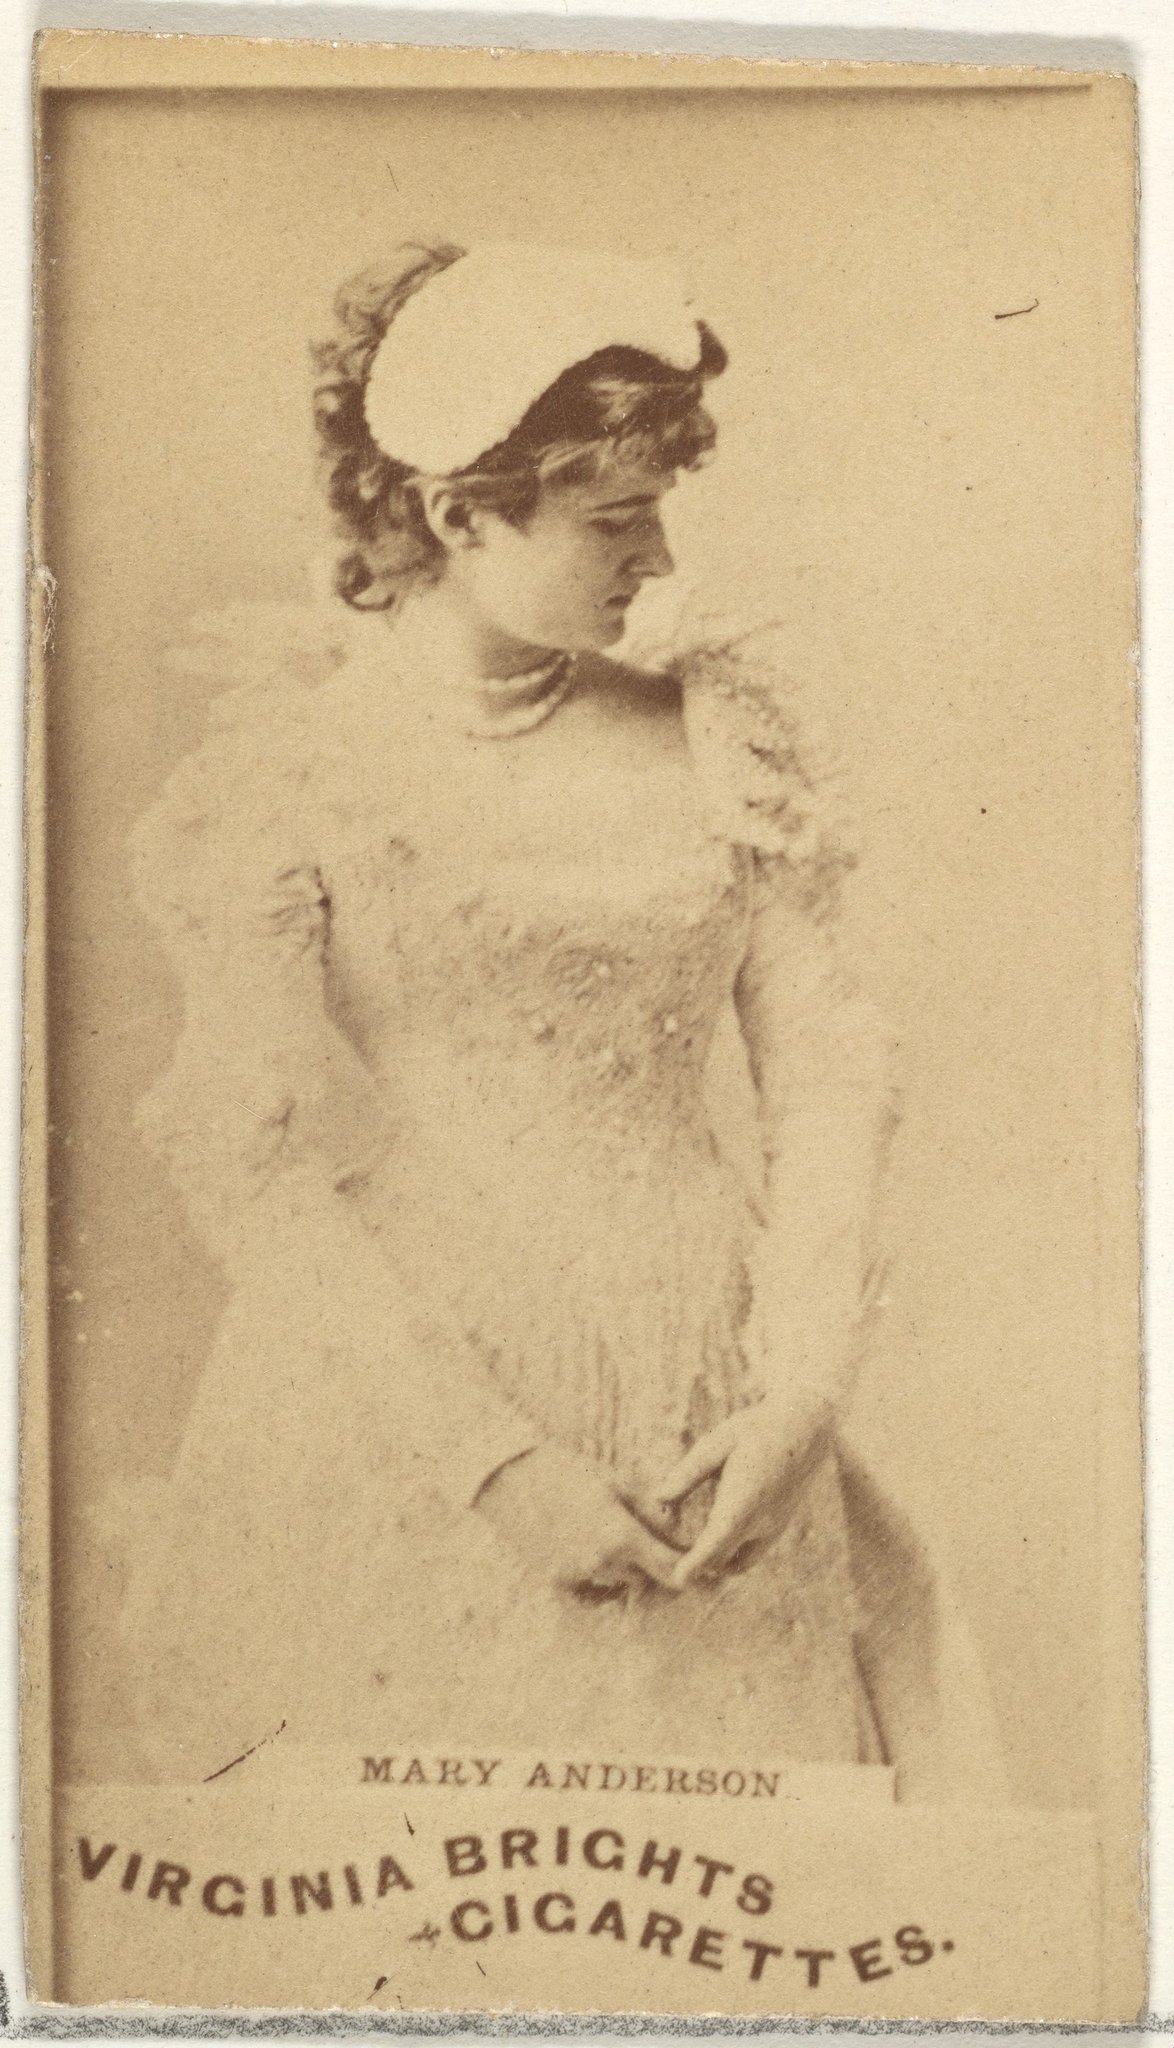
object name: photograph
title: Mary Anderson, from the Actors and Actresses series (N45, Type 1) for Virginia Brights Cigarettes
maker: allen & ginter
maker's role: publisher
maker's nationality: american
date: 1888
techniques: albumen silver print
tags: portraits,profiles,women,actresses